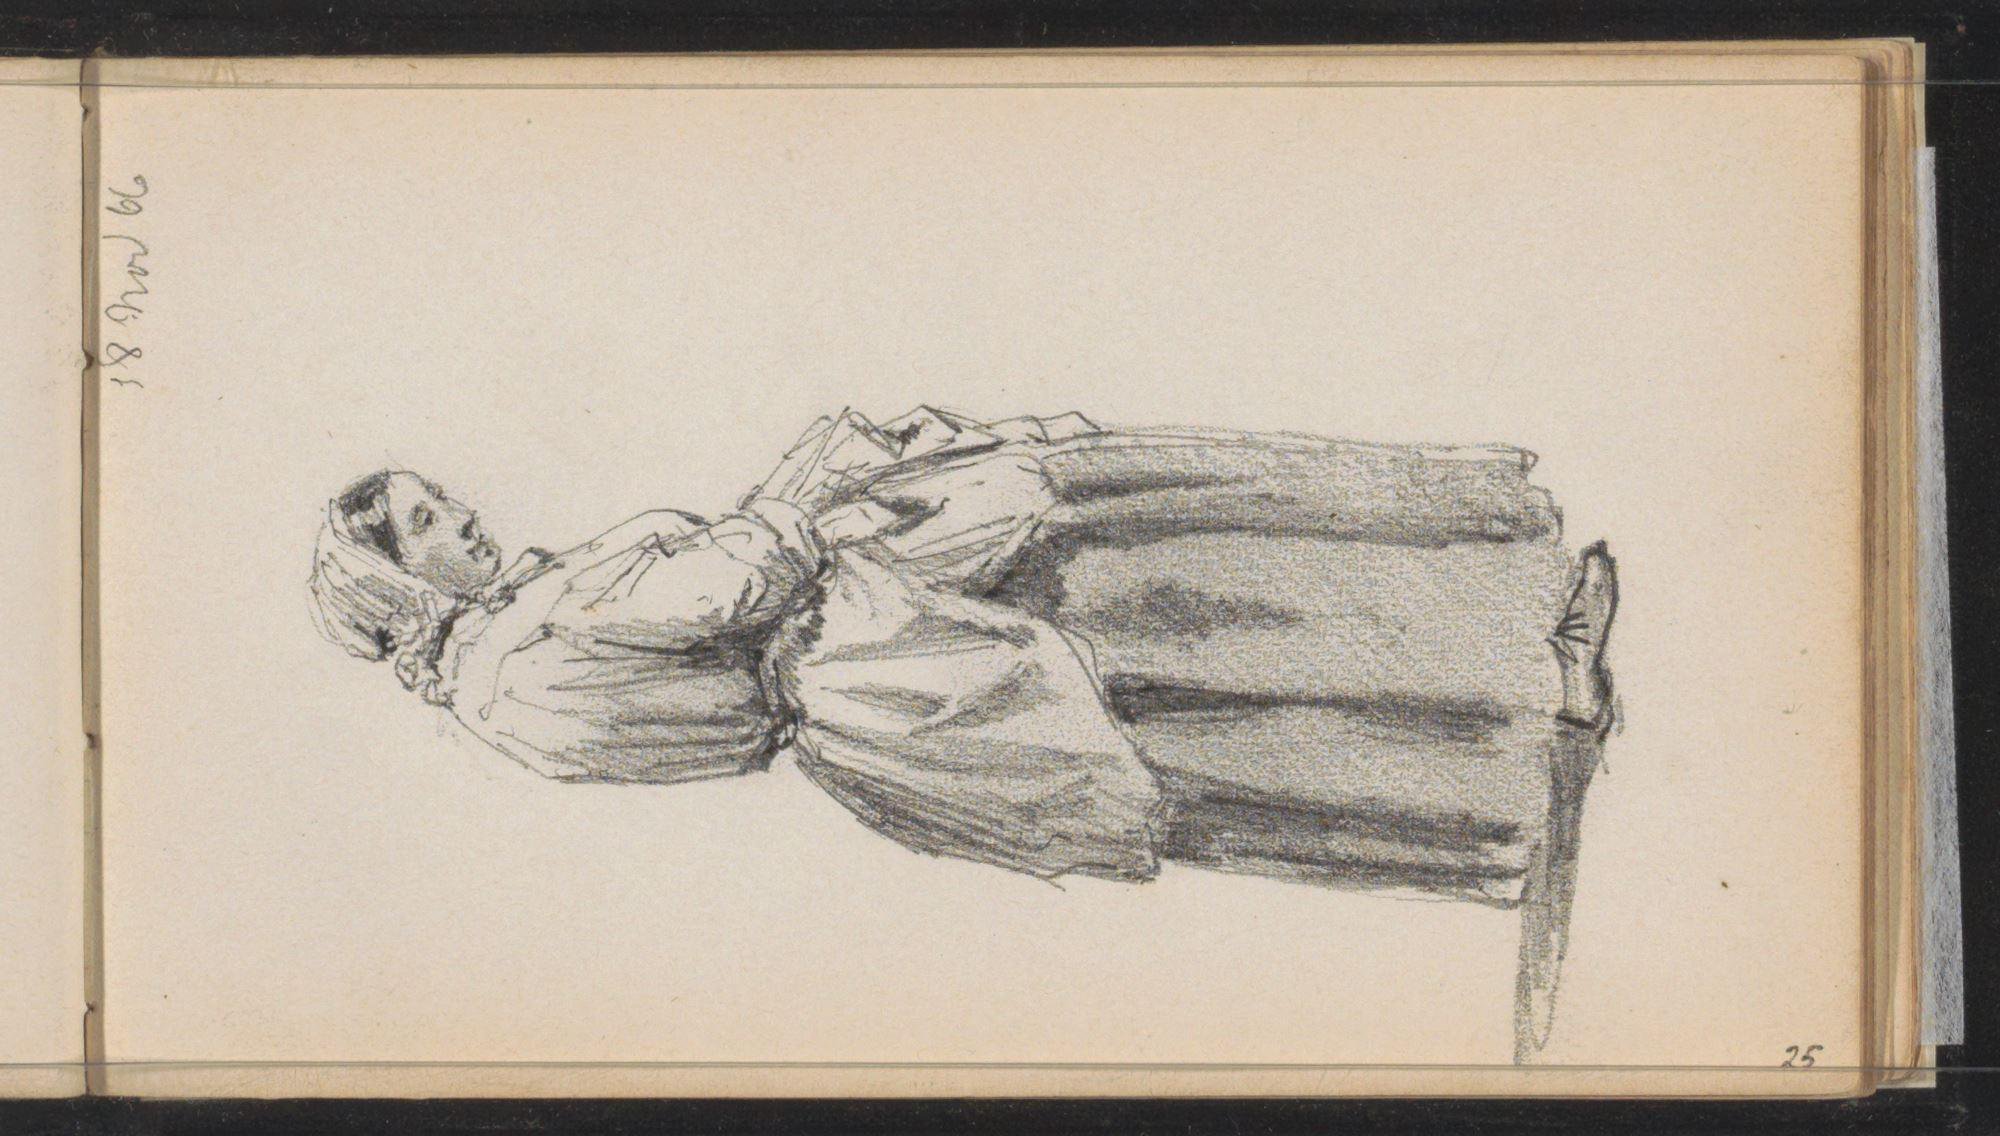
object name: sketchbook leaf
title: Staande vrouw in profiel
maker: cornelis springer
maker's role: draughtsman, painter, print maker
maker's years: 1817-1891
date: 1866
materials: paper, pencil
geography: netherlands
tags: standing figure - aa - female human figure (+ sideview, profile)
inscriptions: date: ‘18 nov 66’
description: Staande vrouw in profiel naar rechts. Blad 25 uit een schetsboek met 44 bladen.